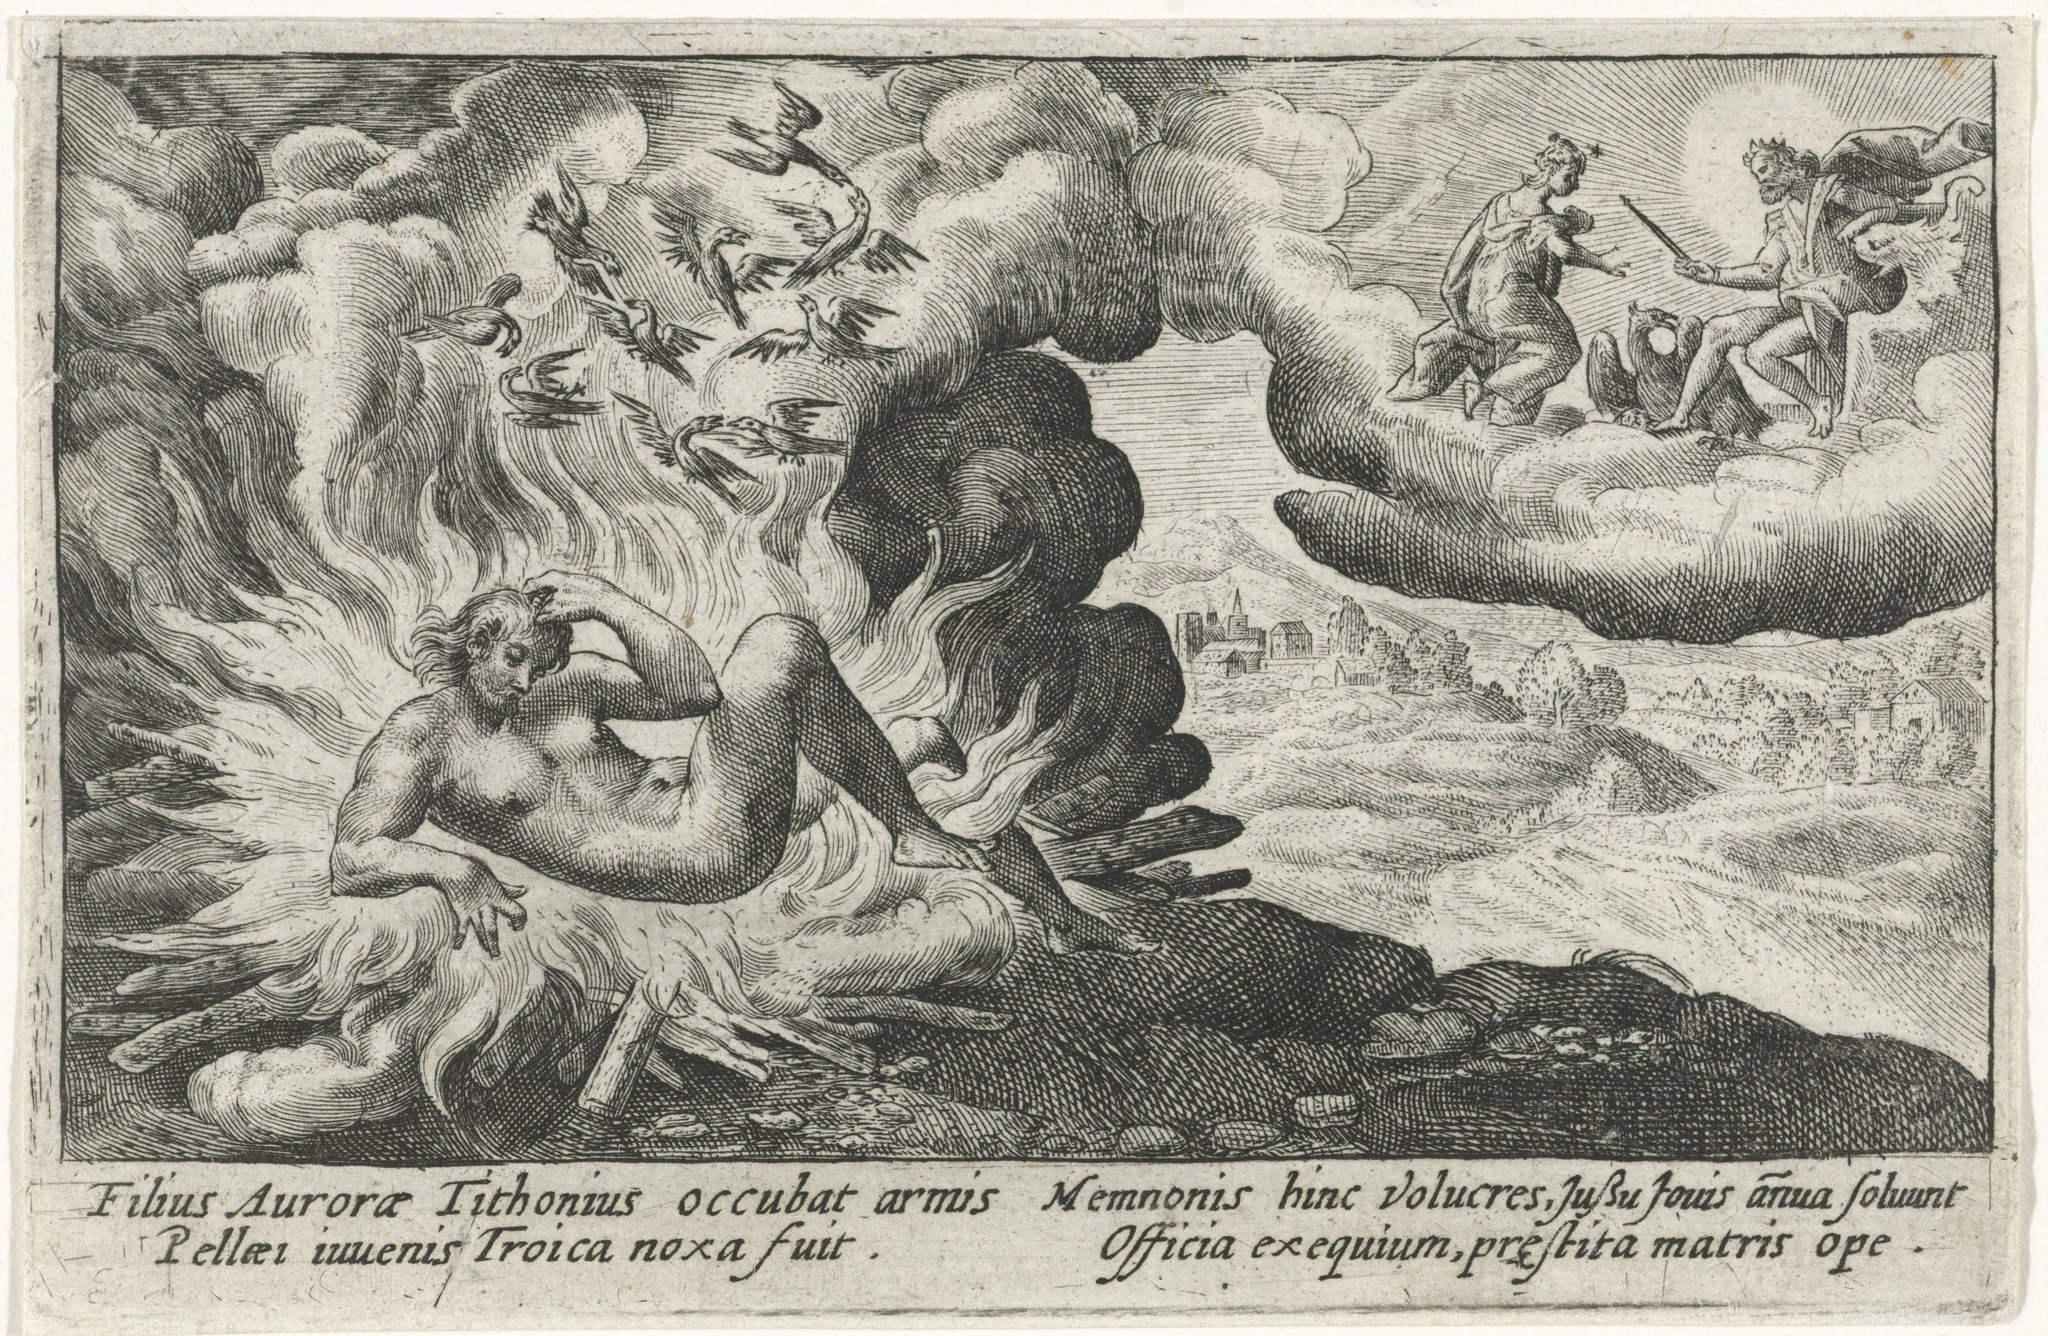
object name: print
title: Memnon op de brandstapel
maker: crispijn van de passe (i)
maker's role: draughtsman, print maker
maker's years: 1564-1637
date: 1602-1607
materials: paper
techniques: engraving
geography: cologne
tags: aurora mourning memnon, memnon's ashes changed into birds: memnon's ashes are changed into birds, the memnonides; they rise from memnon's funeral pyre and fight around his tomb (ovid, metamorphoses xiii 608)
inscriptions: collector's mark: Lugt 2228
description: Het lichaam van Memnon ligt op de brandstapel, de as verandert in vogels die de Memnoniden worden genoemd. Memnon, de zoon van Aurora en Tithonus, werd door Achilles gedood. Rechtsboven Aurora die Jupiter smeekt om haar zoon de onsterfelijkheid te schenken. In de marge een vierregelig onderschrift, in twee kolommen, in het Latijn.